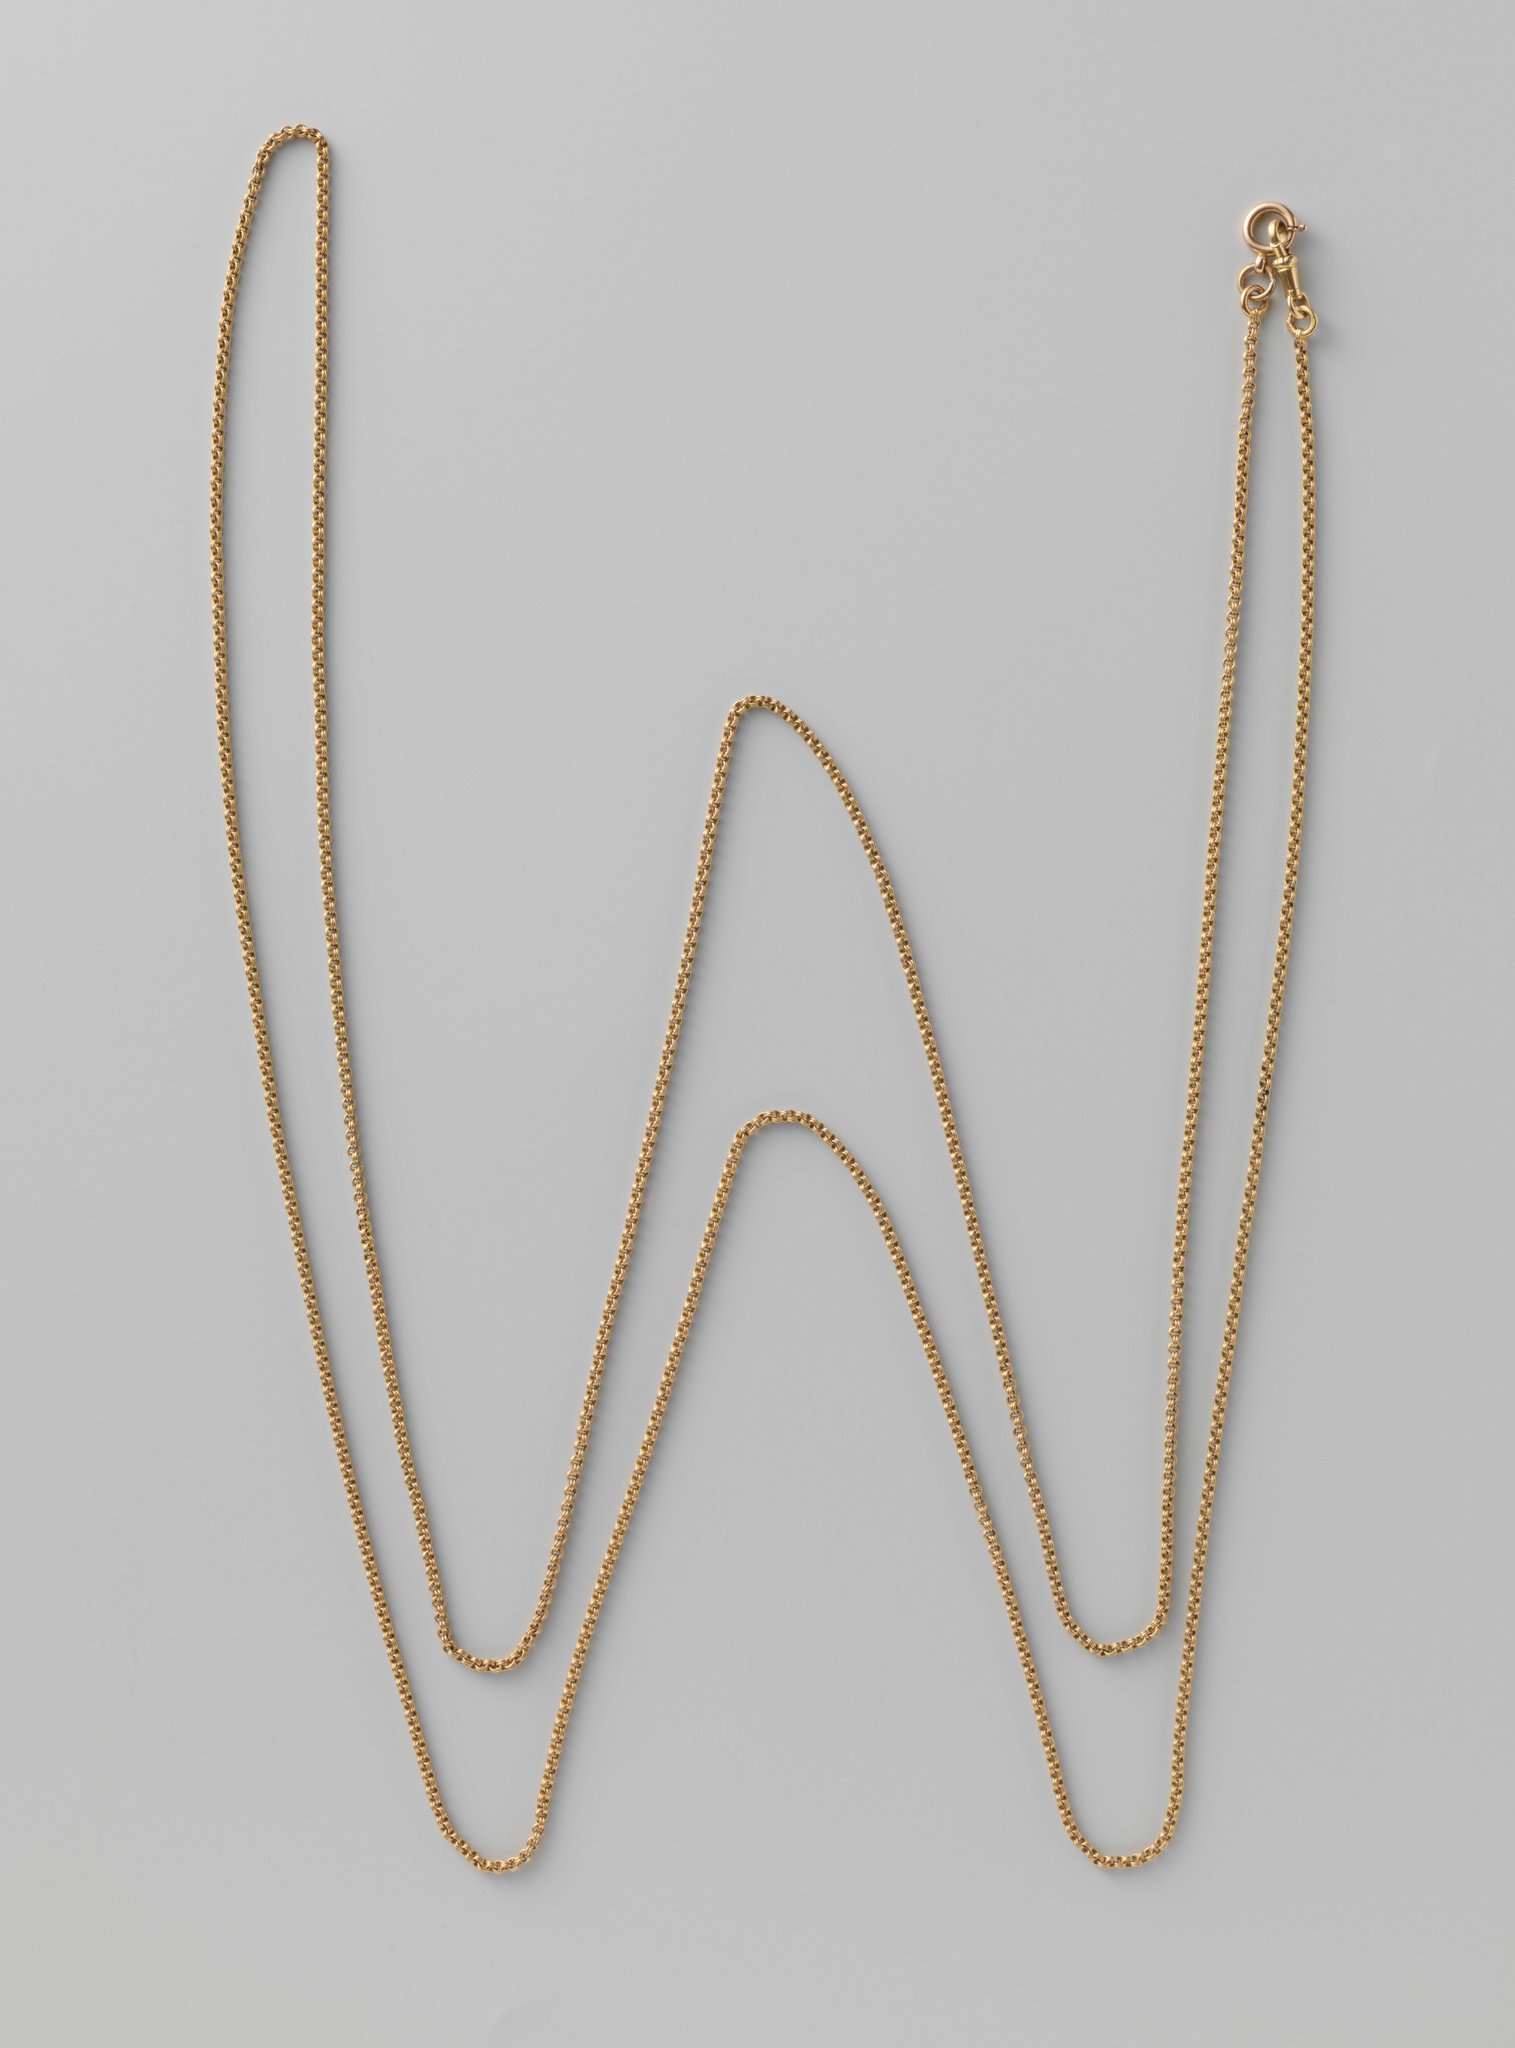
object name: chatelaine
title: Dameshorlogeketting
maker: Anonymous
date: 1850-1900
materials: gold